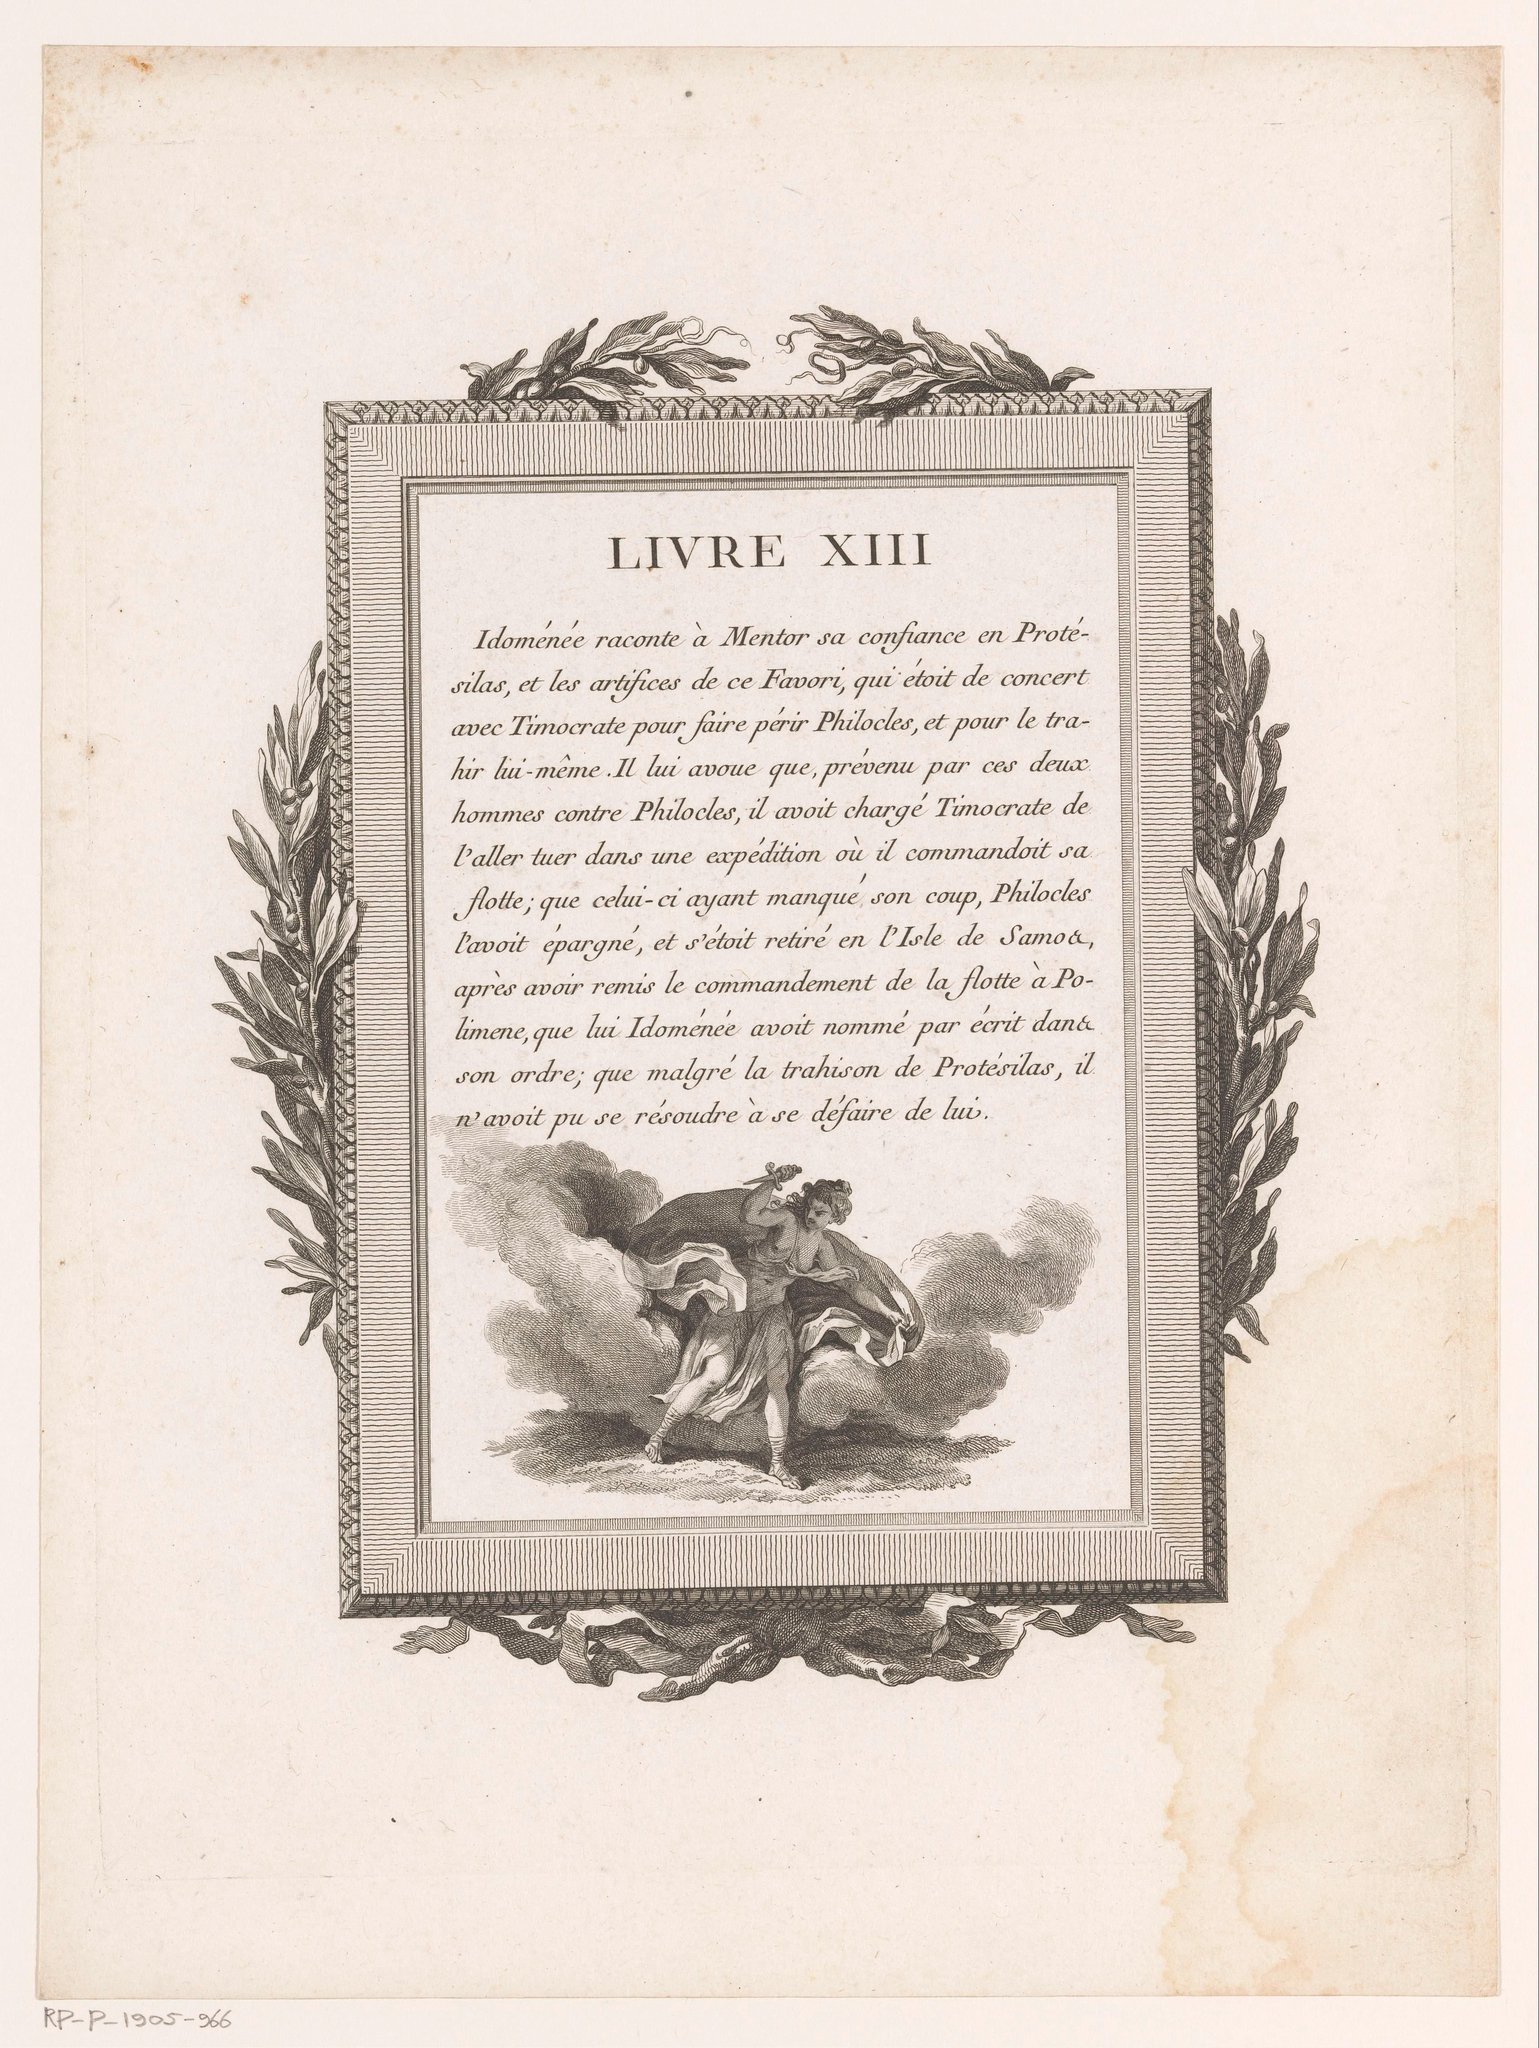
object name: book illustration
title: Omkaderde Franse tekst met olijftakken en mythologisch figuur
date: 1785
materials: paper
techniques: engraving, etching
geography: france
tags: (fenelon, telemachus) specific works of literature (with author, title), ornament ~ festoon, garland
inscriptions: collector's mark: Lugt 2228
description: Twaalfregelige Franse tekst, getiteld 'Livre XIII' met daaronder een afbeelding van een mythologisch figuur met een dolk in haar hand. Het geheel wordt gekaderd door een sierlijst met olijftakken en onderaan een strik.